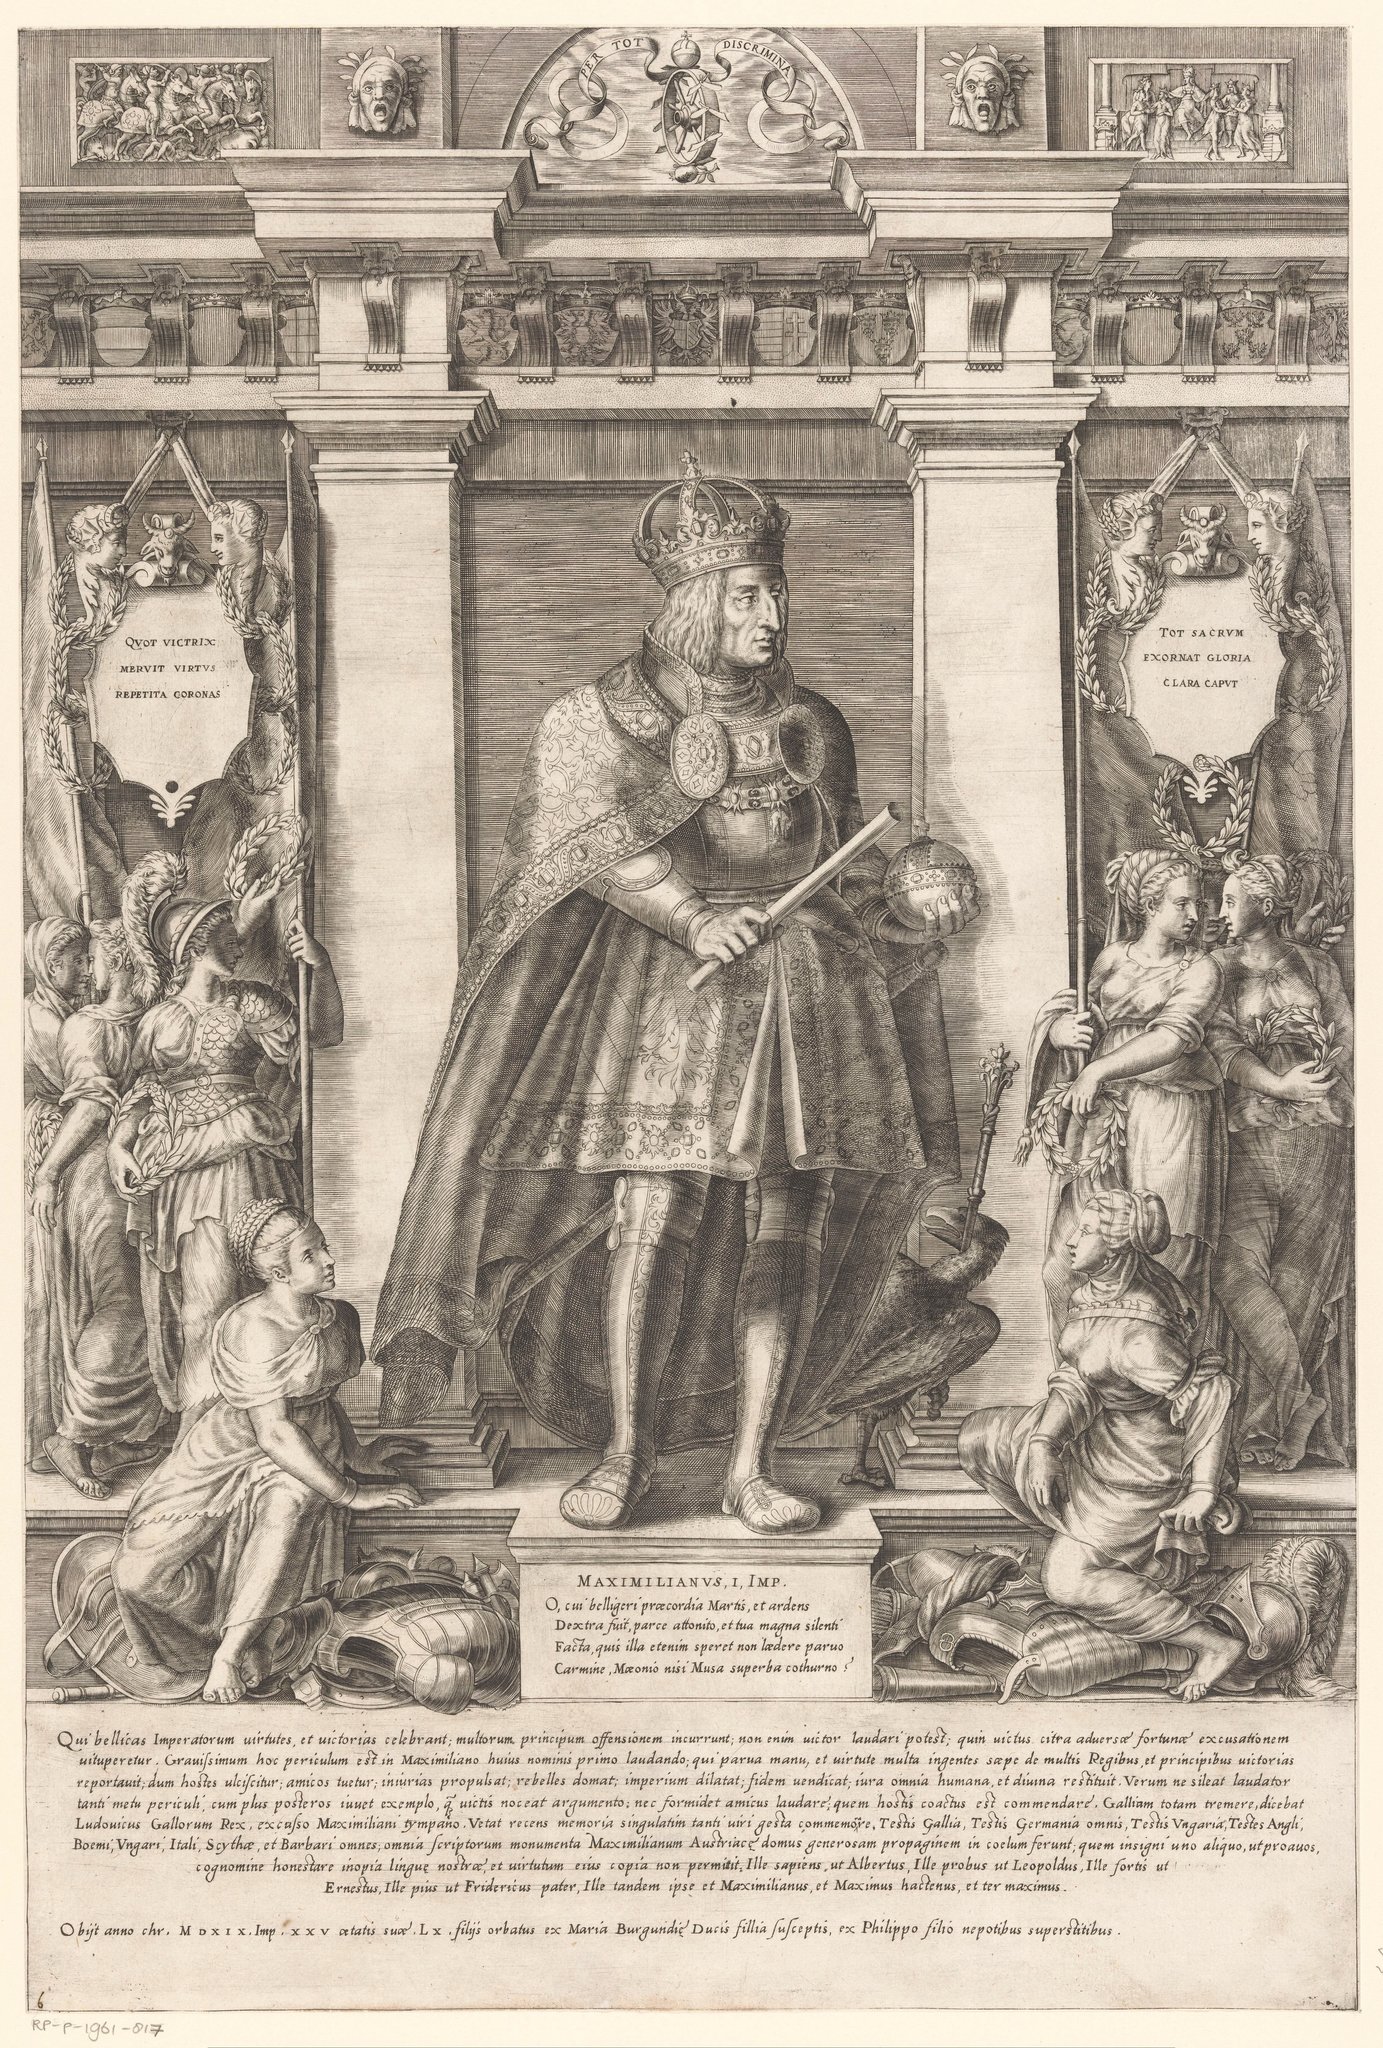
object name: print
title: Portret van keizer Maximiliaan I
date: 1569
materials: paper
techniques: engraving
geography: italy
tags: maximilian i (holy roman emperor), historical persons, ruler, sovereign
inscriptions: collector's mark: Lugt 2228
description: Deze prent maakt deel uit van een reeks van 58 prenten. Het meerendeel van de prenten bevat portretten van 74 leden van het Oostenrijkse Huis, naar tekeningen door Francesco Terzio, die deels getekend zijn naar de 28 levensgrote bronzen beelden die rond de cenotaaf van Maximiliaan I in de Hofkirche te Innsbruck staan.